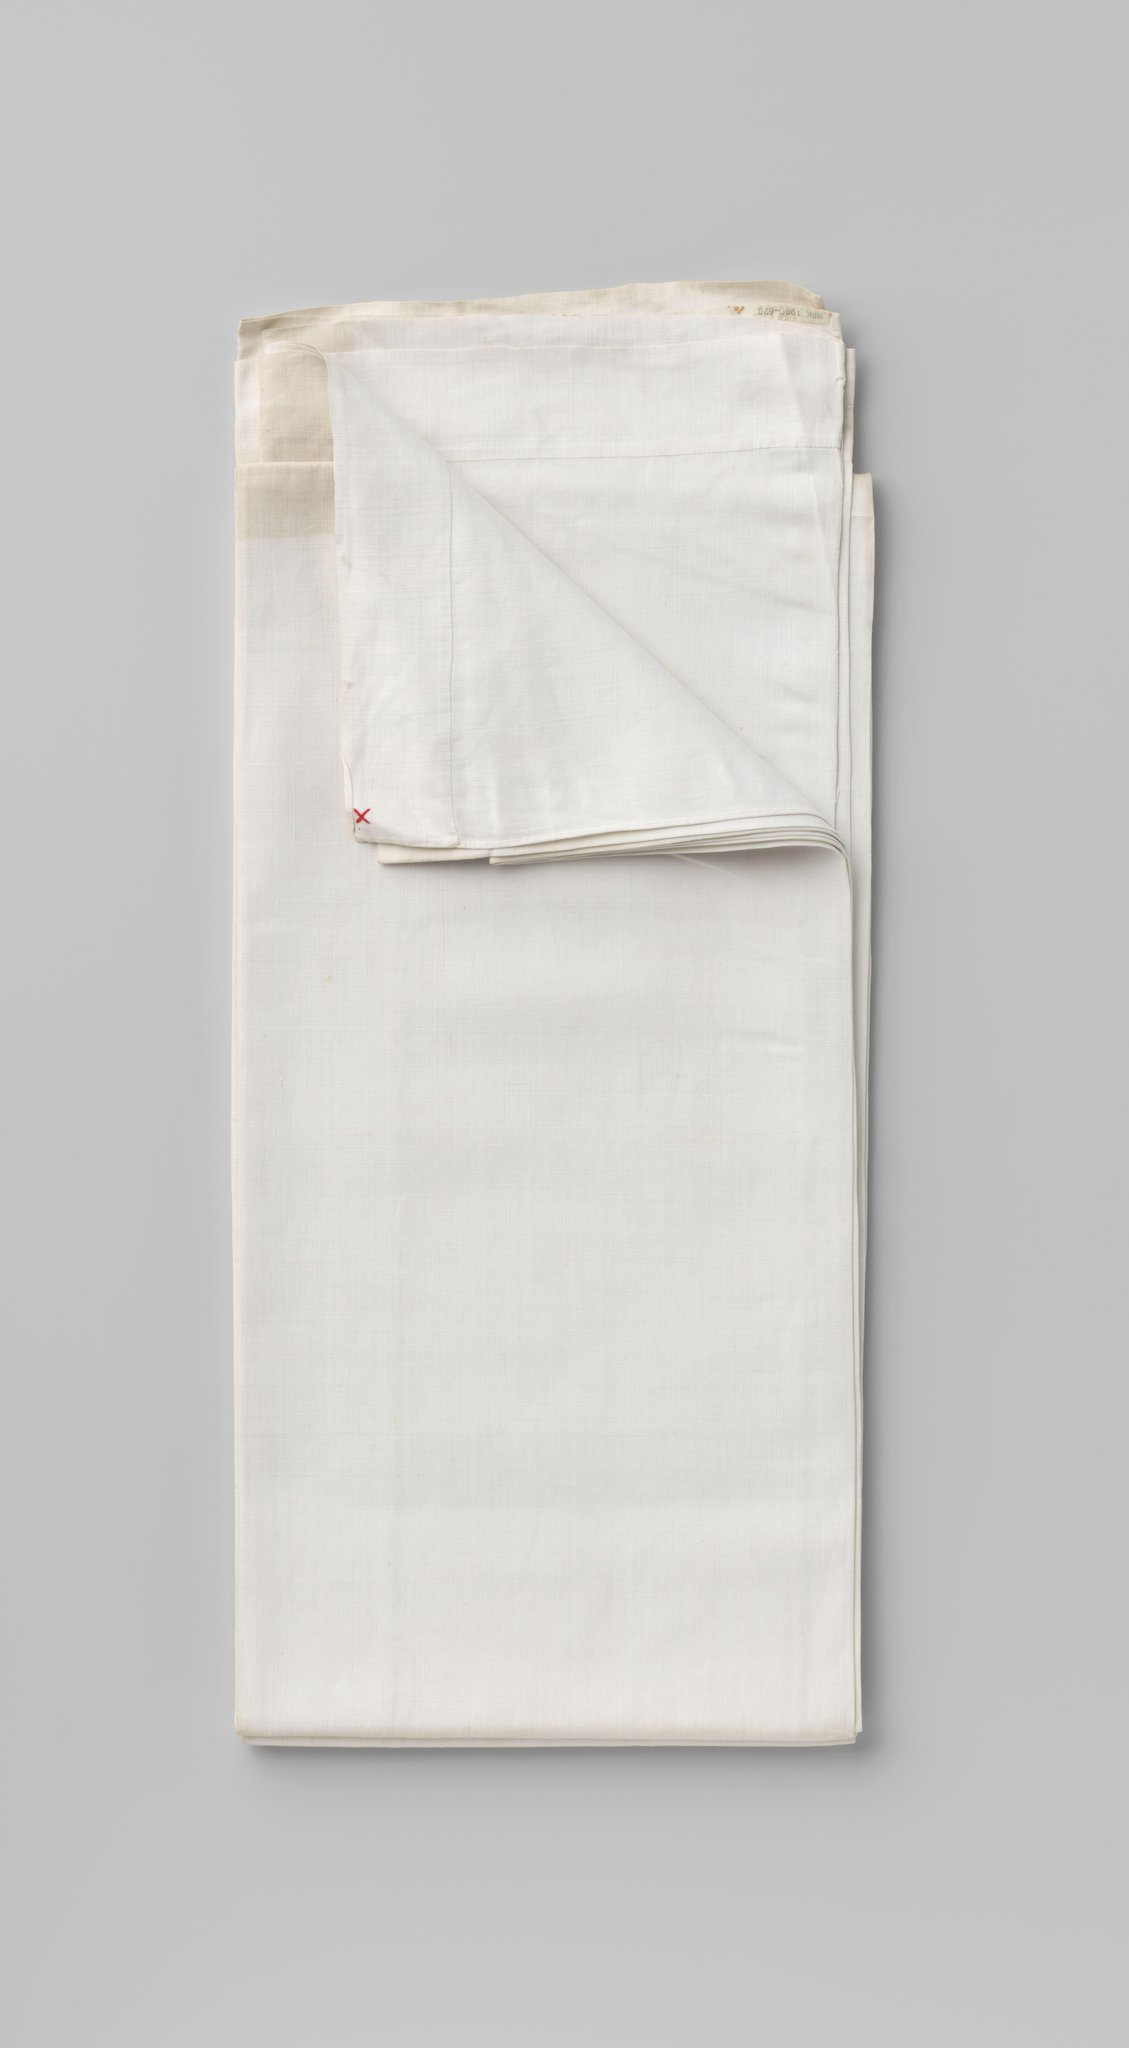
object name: beddenlaken, laken object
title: Laken. Merk: CH 20.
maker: Anonymous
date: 1750-1790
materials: linen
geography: northern netherlands